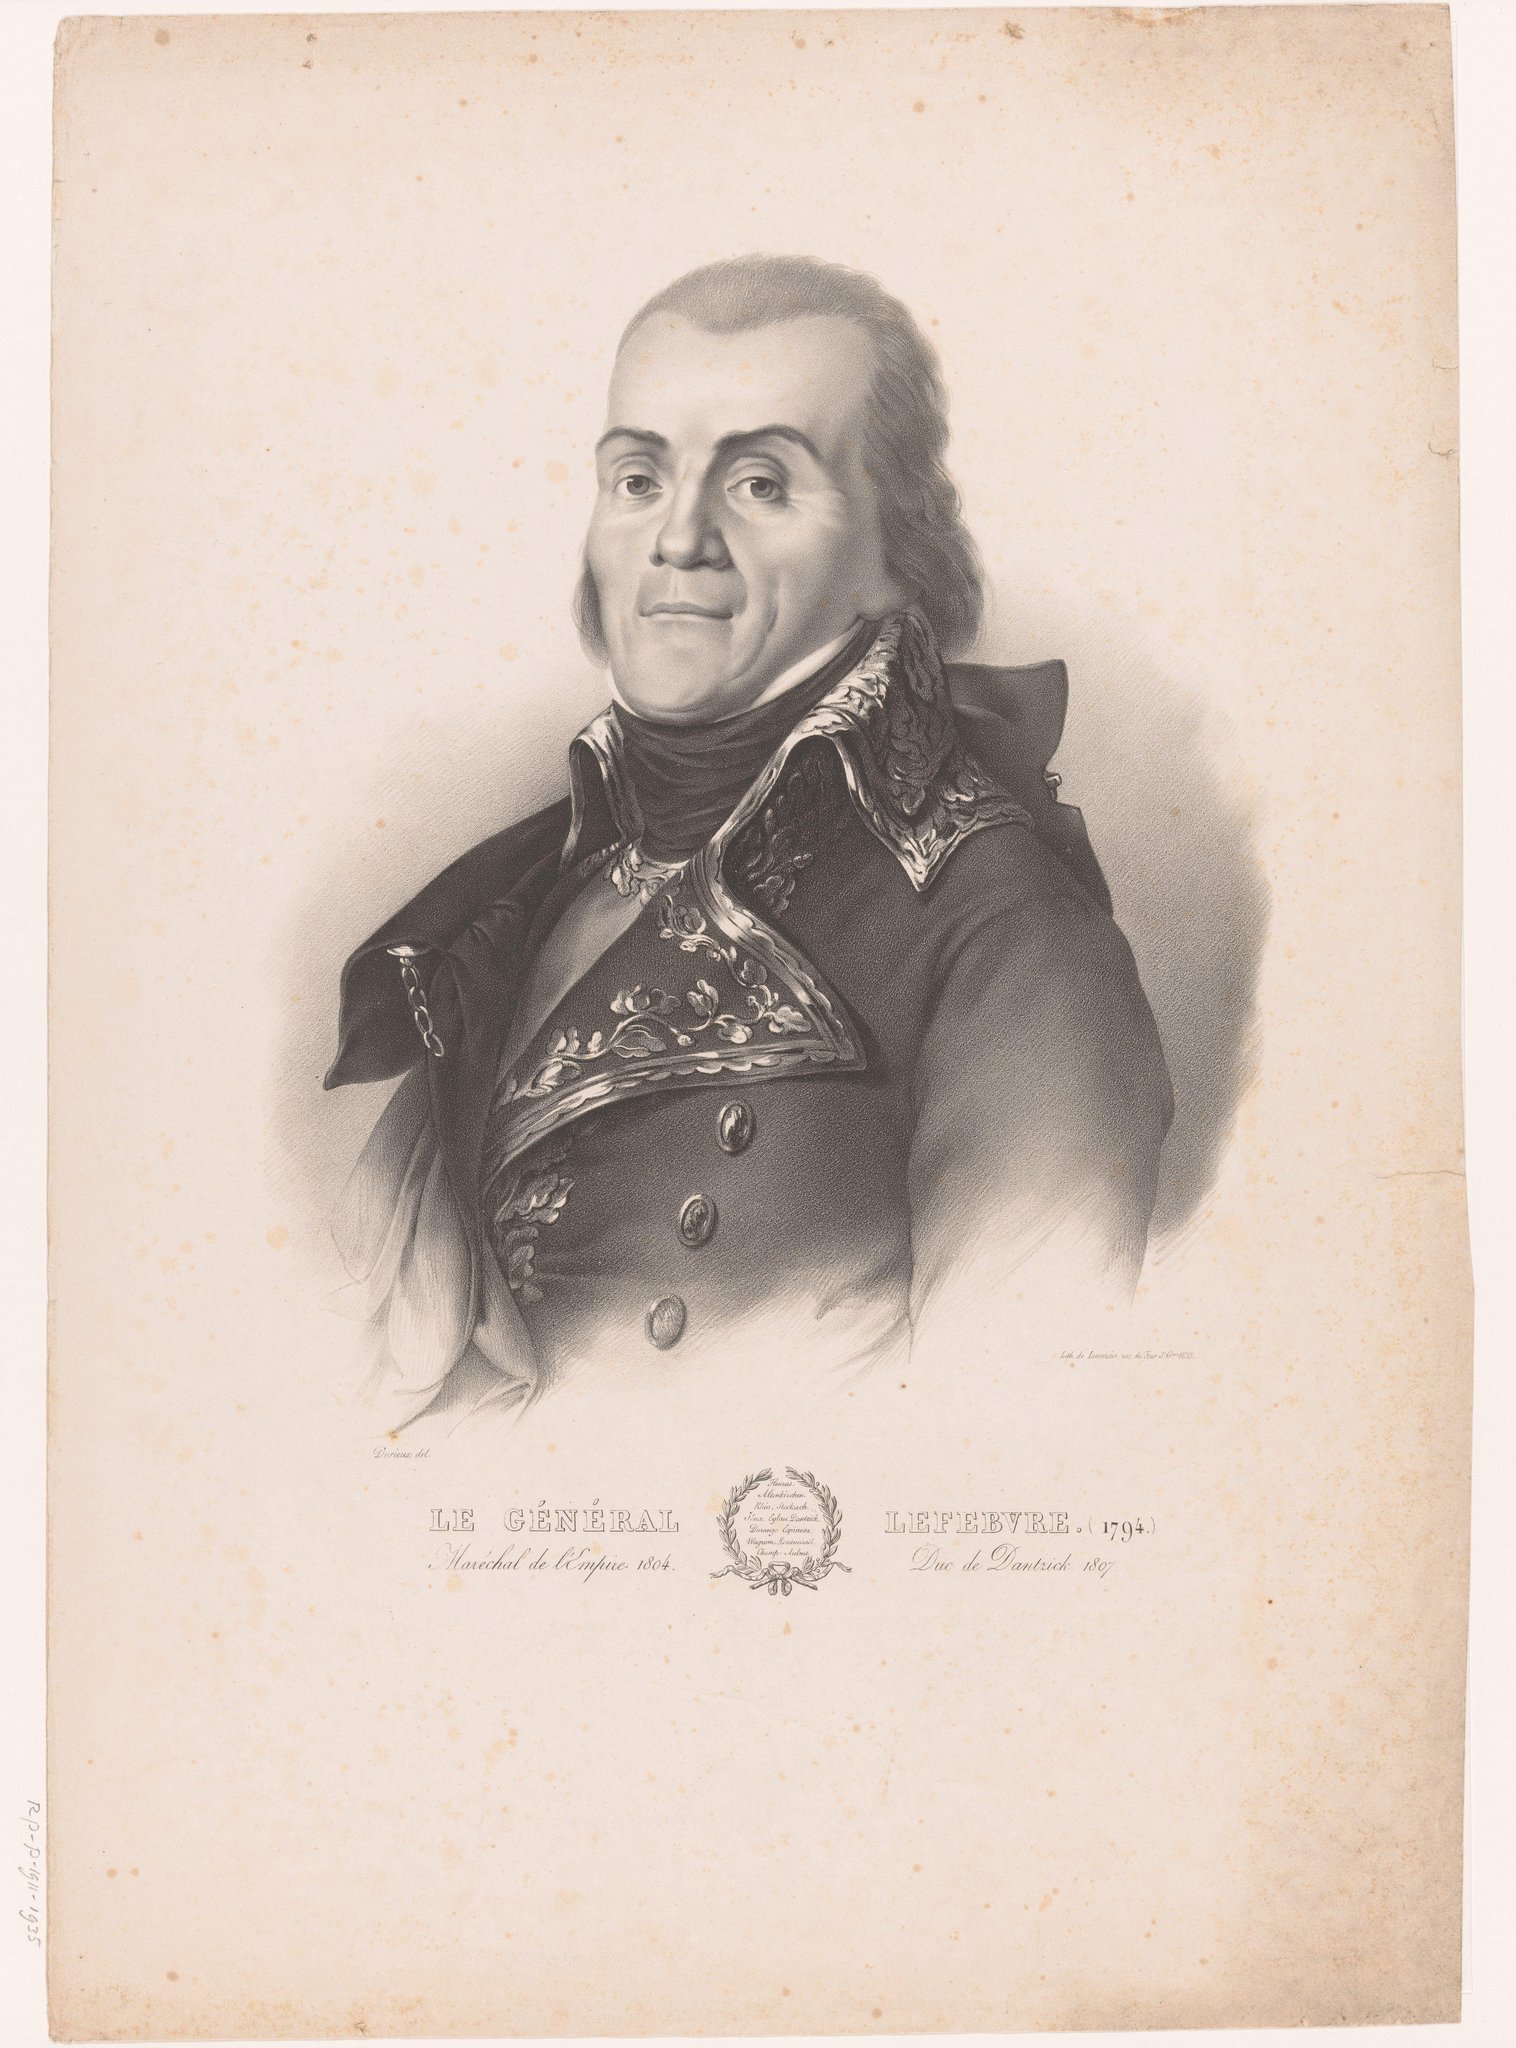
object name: print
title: Le général Lefebvre (1794)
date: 1829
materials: paper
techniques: lithograph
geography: paris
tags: historical persons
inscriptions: collector's mark: Lugt 2228a